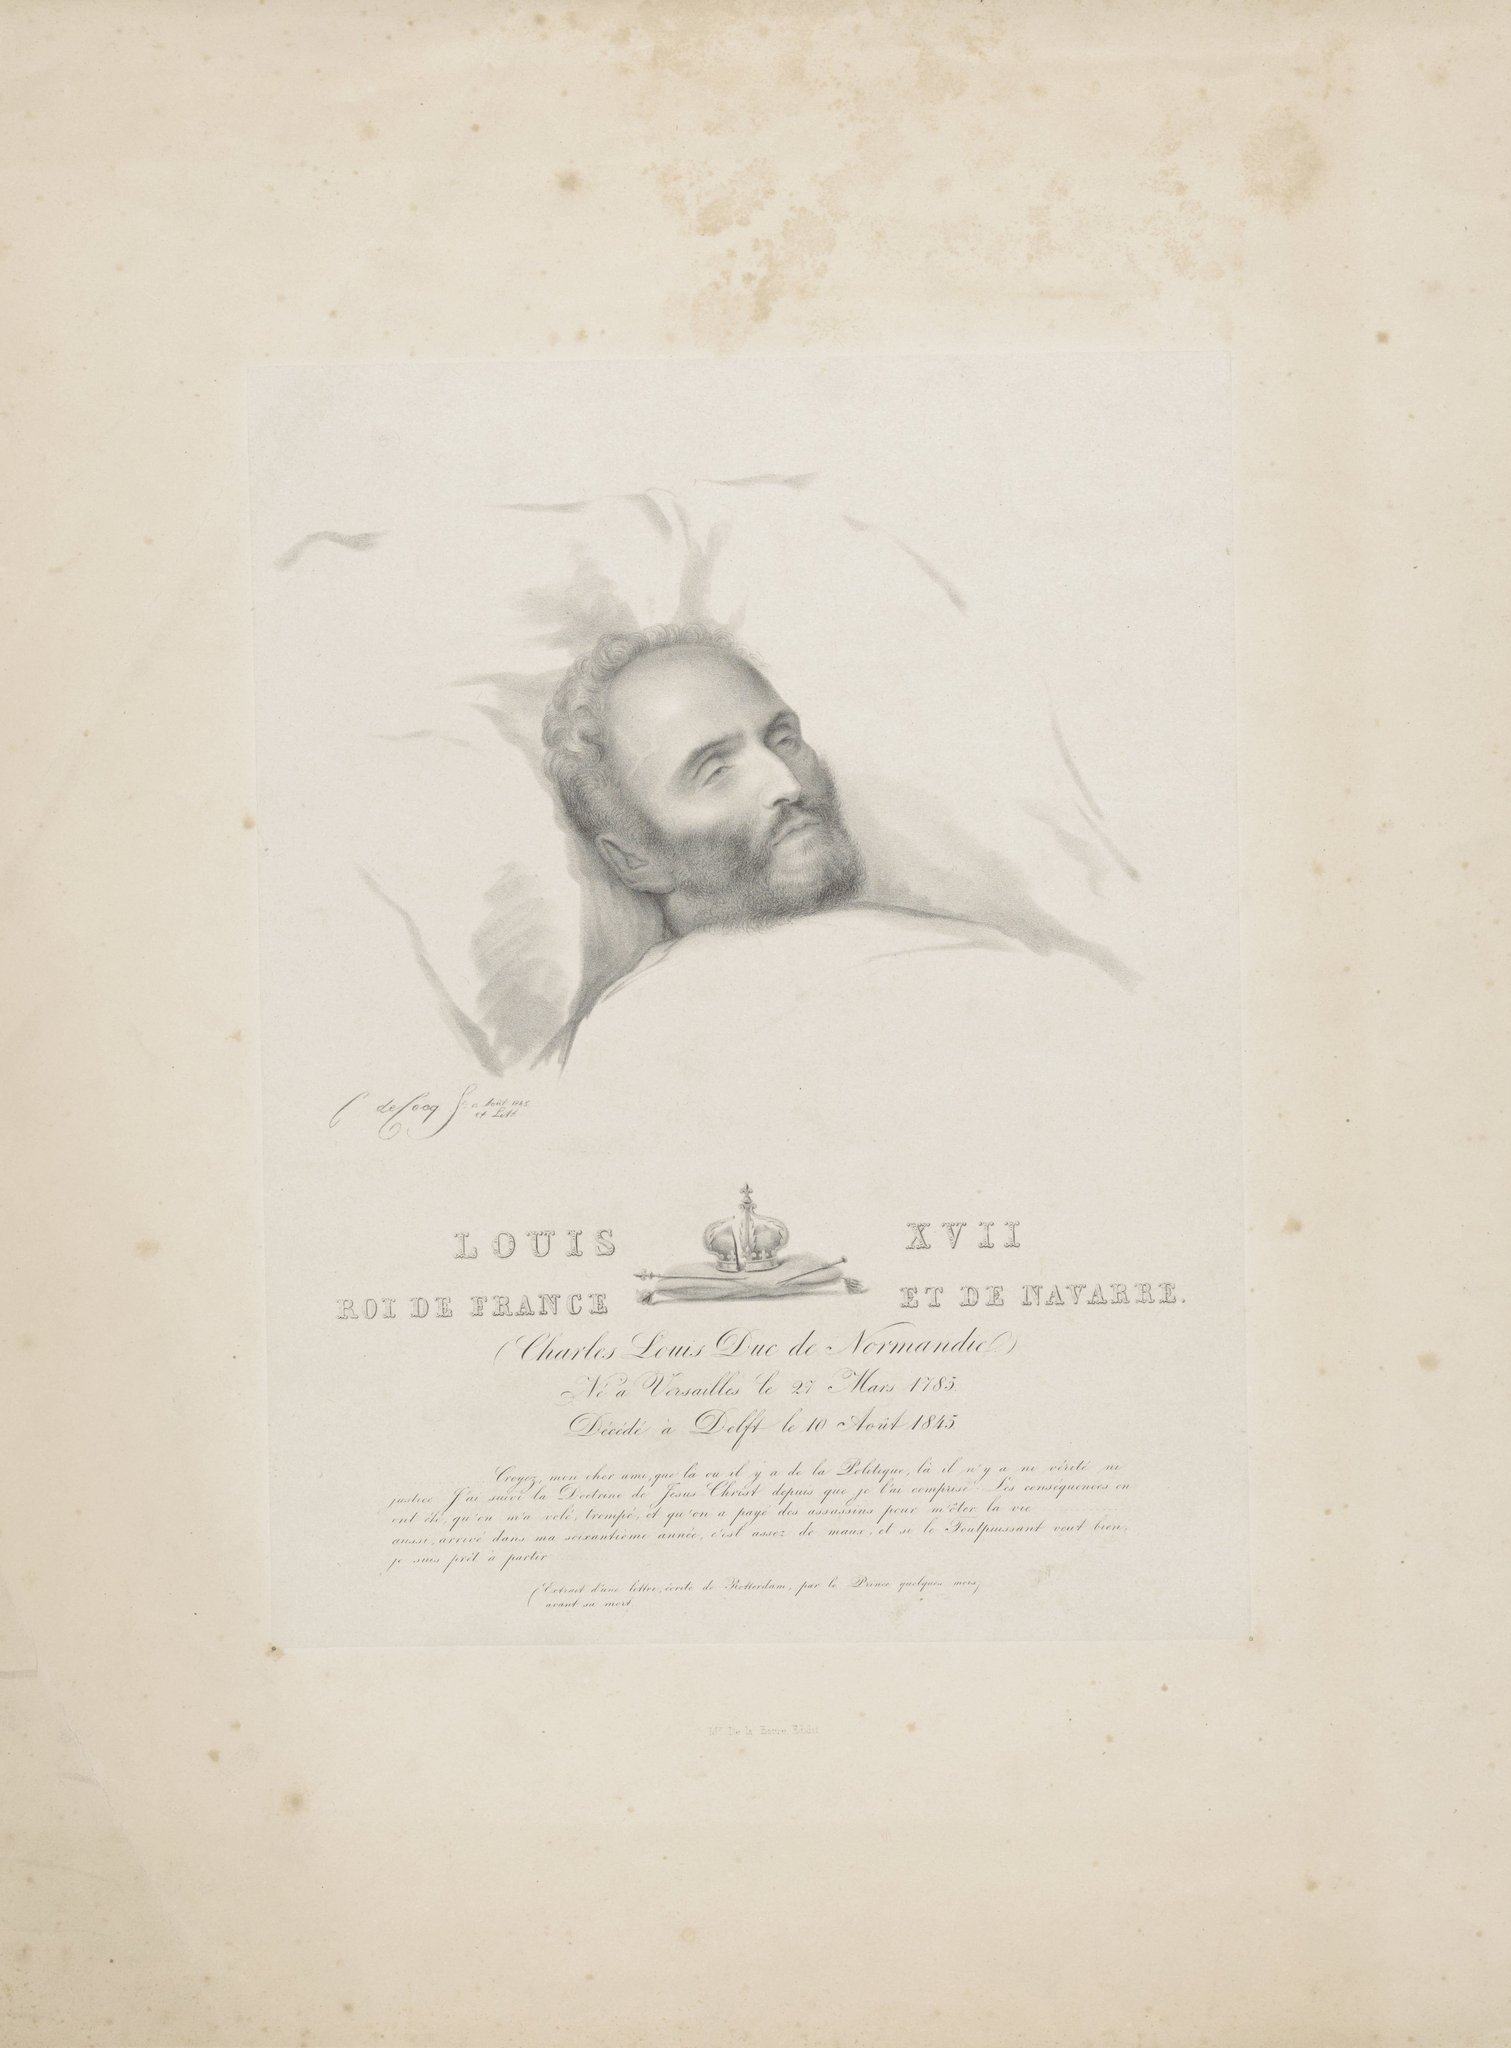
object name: print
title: Louis XVII Roi de France et de Navarre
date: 1845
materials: paper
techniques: lithograph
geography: netherlands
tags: karl wilhelm naundorff, deathbed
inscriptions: collector's mark: Lugt 2228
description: De gestorvene ligt op een bed met het deken tot onder zijn kin. Zijn ogen zijn half open. Onder het portret de naam van Koning Lodewijk XVII en regalia. Karl Wilhelm Naundorff beweerde, onterecht, de verdwenen koning van Frankrijk Lodewijk XVII te zijn. Onder de naam, geboorte- en sterfdatum staat een uittreksel uit een brief die hij schreef enkele maanden voor zijn dood.